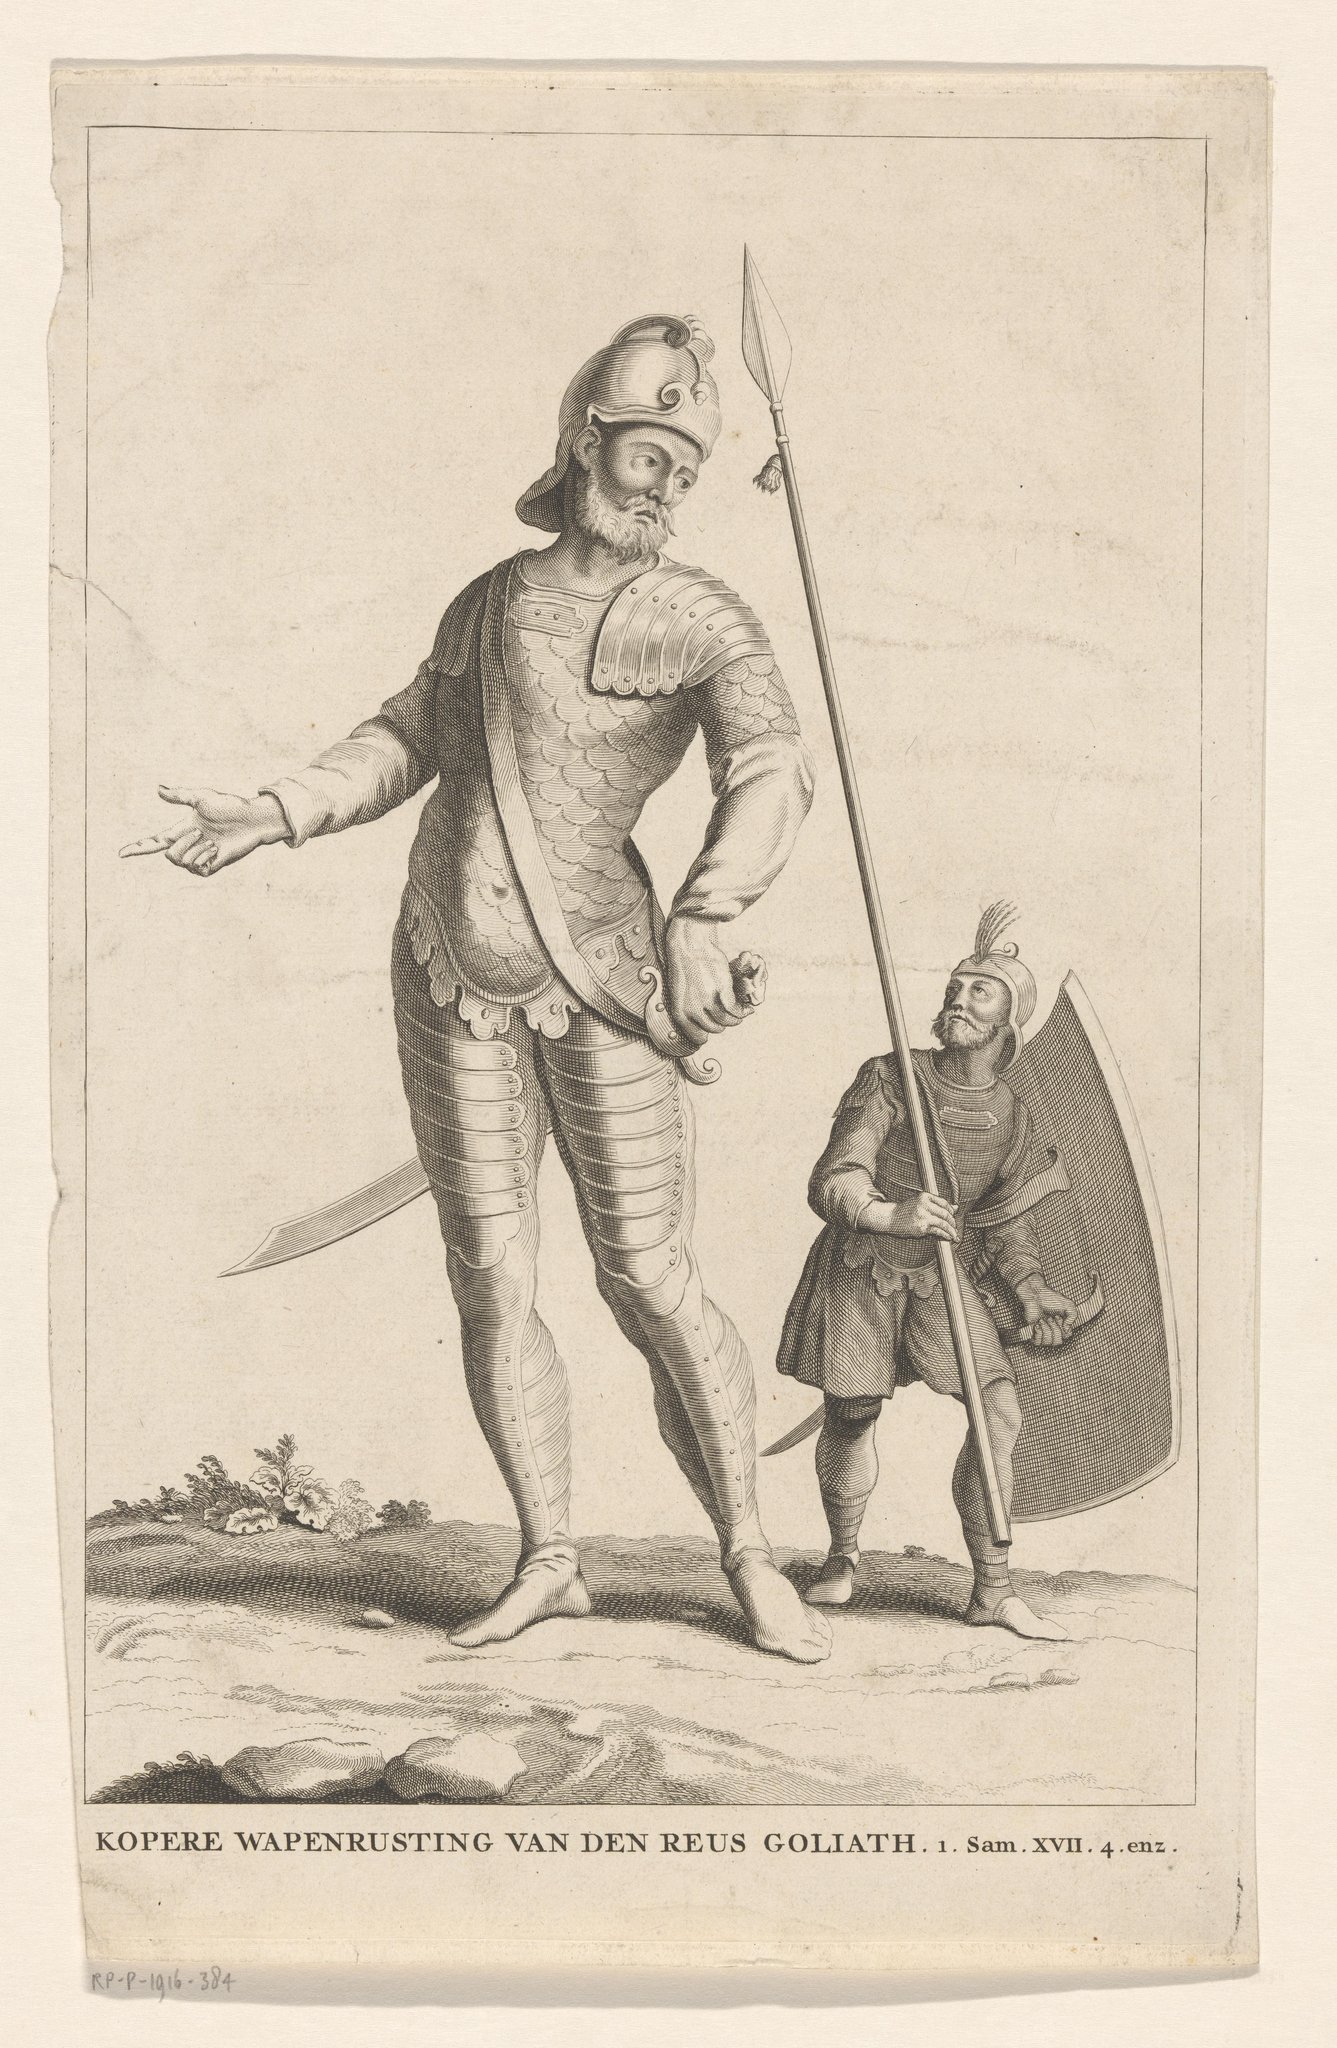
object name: print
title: Wapenrusting van Goliath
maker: Anonymous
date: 1731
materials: paper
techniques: engraving, etching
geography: northern netherlands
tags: story of david and goliath (1 samuel 17)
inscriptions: collector's mark: Lugt 2228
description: Prent waarschijnlijk uit: Calmet, Augustinus. Byvoegzel tot het Algemeen Groot Historisch, Oordeelkundig, Chronologisch, Geografisch, en Letterlyk Naam- en Woord-Boek, van den Ganschen H. Bybel (...). [Vertaald uit het Frans door] Jakob van Ostade. Amsterdam: De Wetsteins en Smith, Leiden: Samuel Luchtmans, 1731.